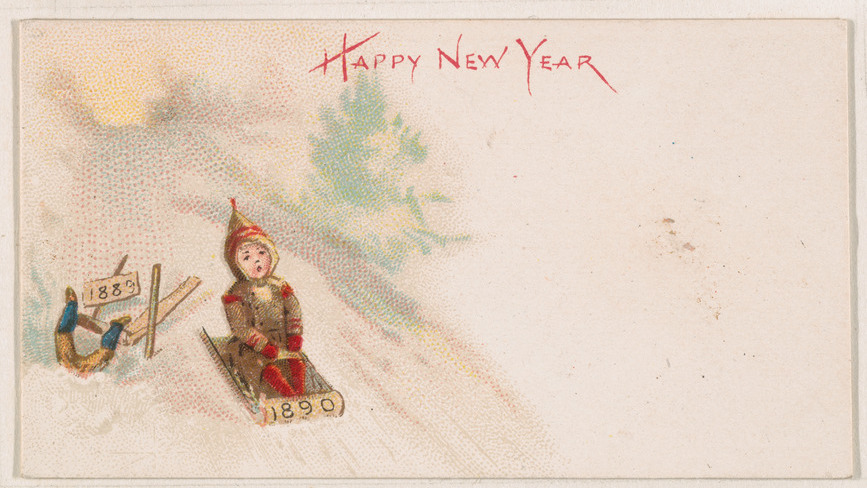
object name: print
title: Happy New Year, from the New Years 1890 series (N227) issued by Kinney Bros.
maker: kinney brothers tobacco company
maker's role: publisher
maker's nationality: american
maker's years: 1869-2011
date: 1889-1890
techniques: color lithograph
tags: girls,sledging,winter,snow